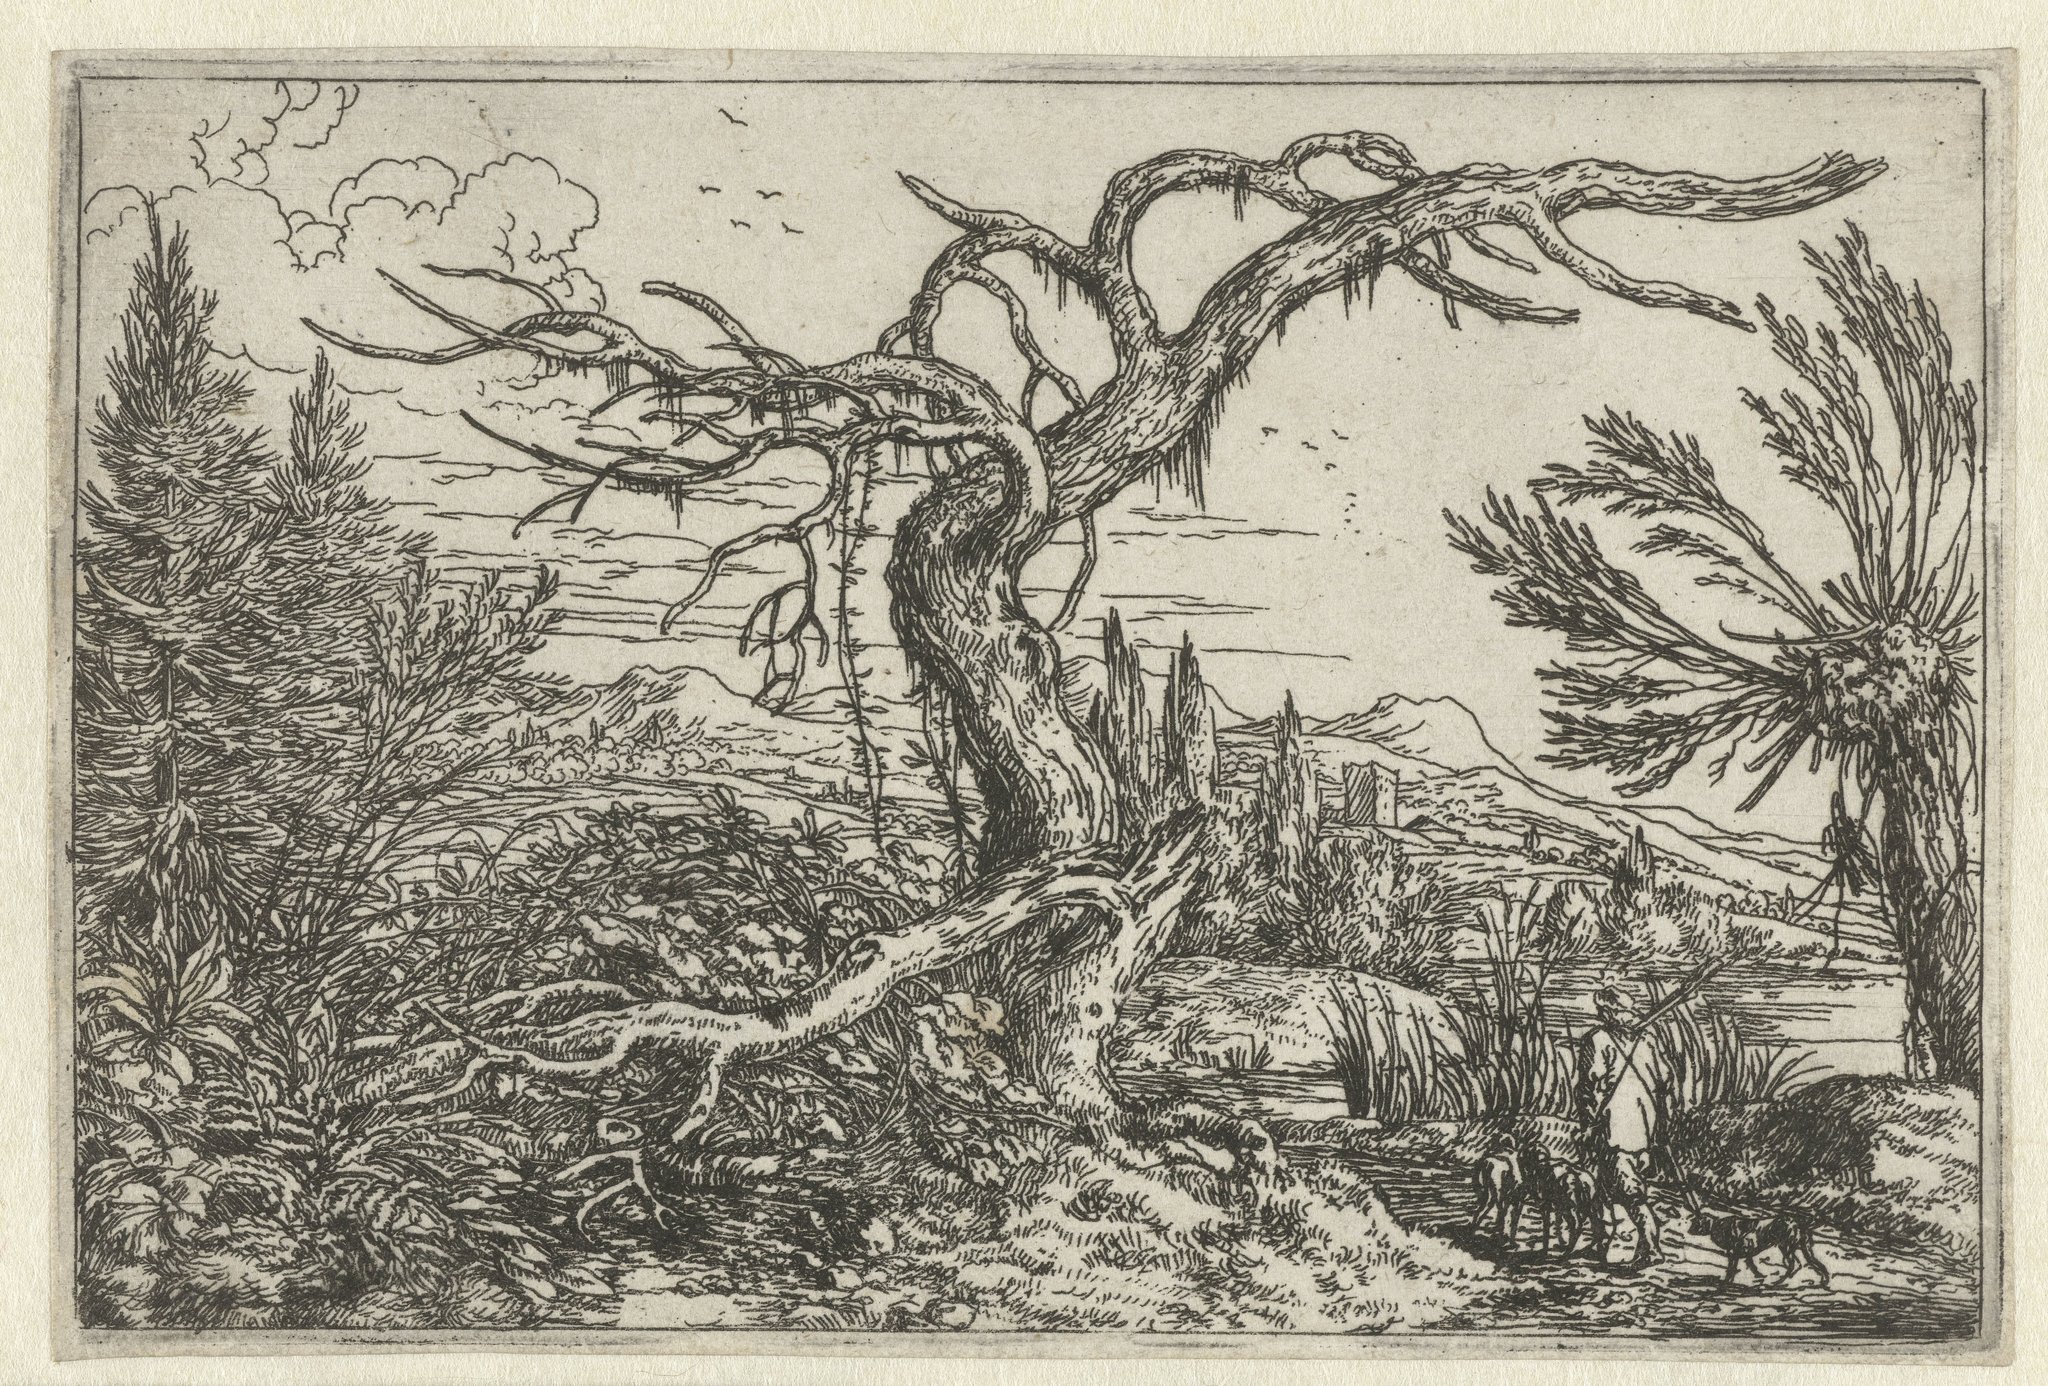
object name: print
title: Landschap met de dorre boom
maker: jonas umbach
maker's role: print maker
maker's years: 1624-1693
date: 1634-1693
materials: paper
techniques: etching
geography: augsburg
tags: low hill country, trees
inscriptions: collector's mark: Lugt 2760, collector's mark: Lugt 2228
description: Heuvelachtig landschap met op de voorgrond een dode boom. Over het pad loopt een jager met drie honden.